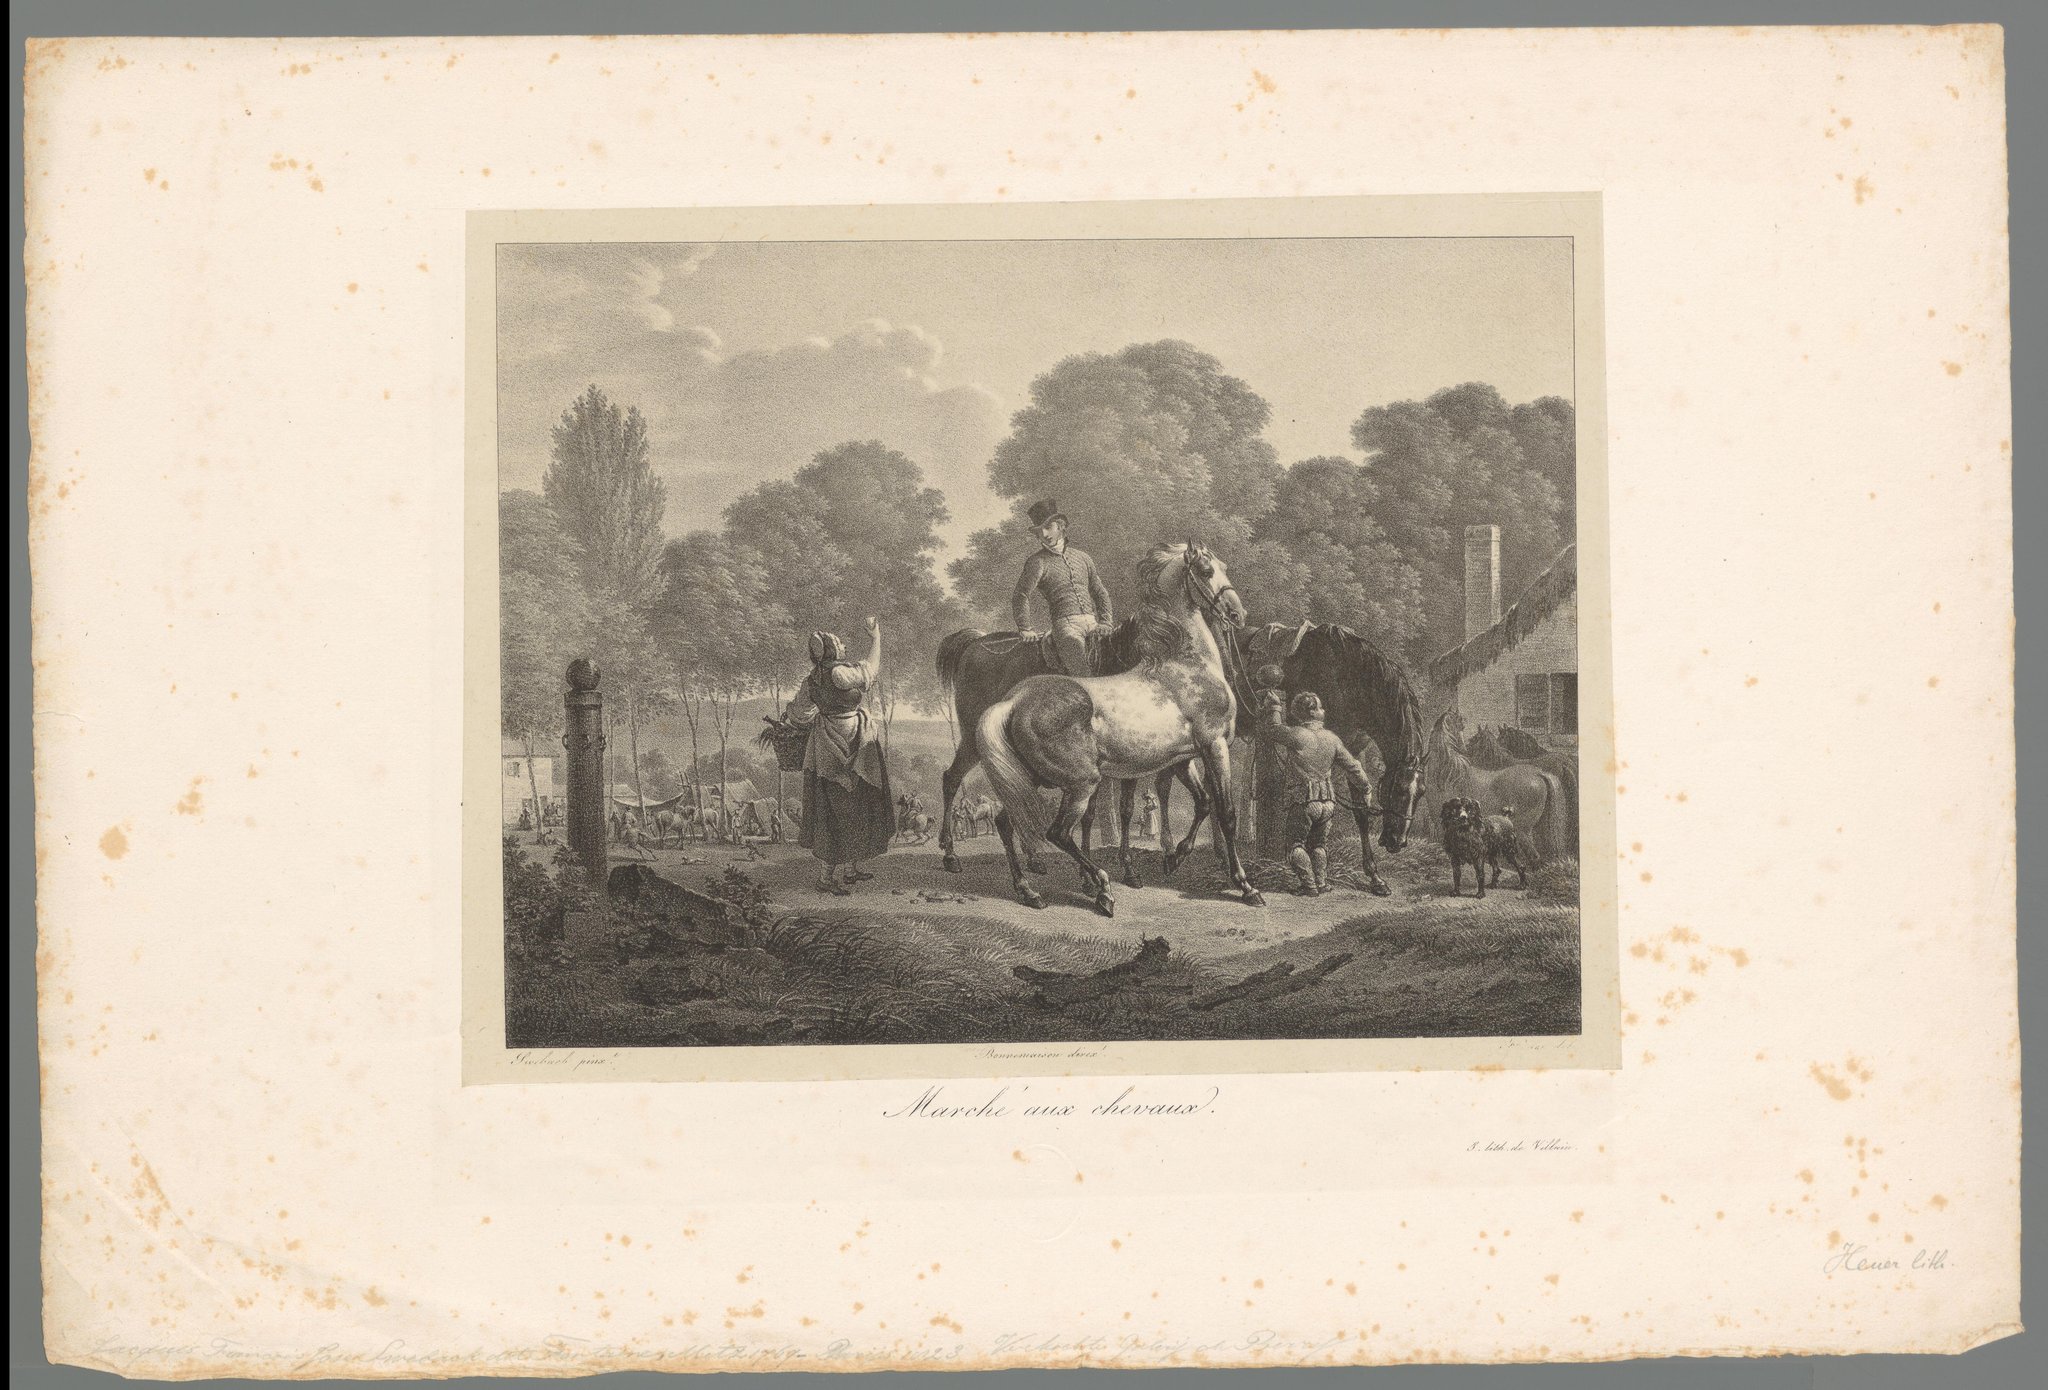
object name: print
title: Paardenmarkt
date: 1823-1826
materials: paper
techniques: lithograph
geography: paris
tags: horse, market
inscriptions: collector's mark: Lugt 2228, check stamp: Lugt 4729, : ‘Jacques Francois Josep Sweback dite Fontaine, Metz 1769-Parijs 1823. Verkocht Galerij de Berry.’